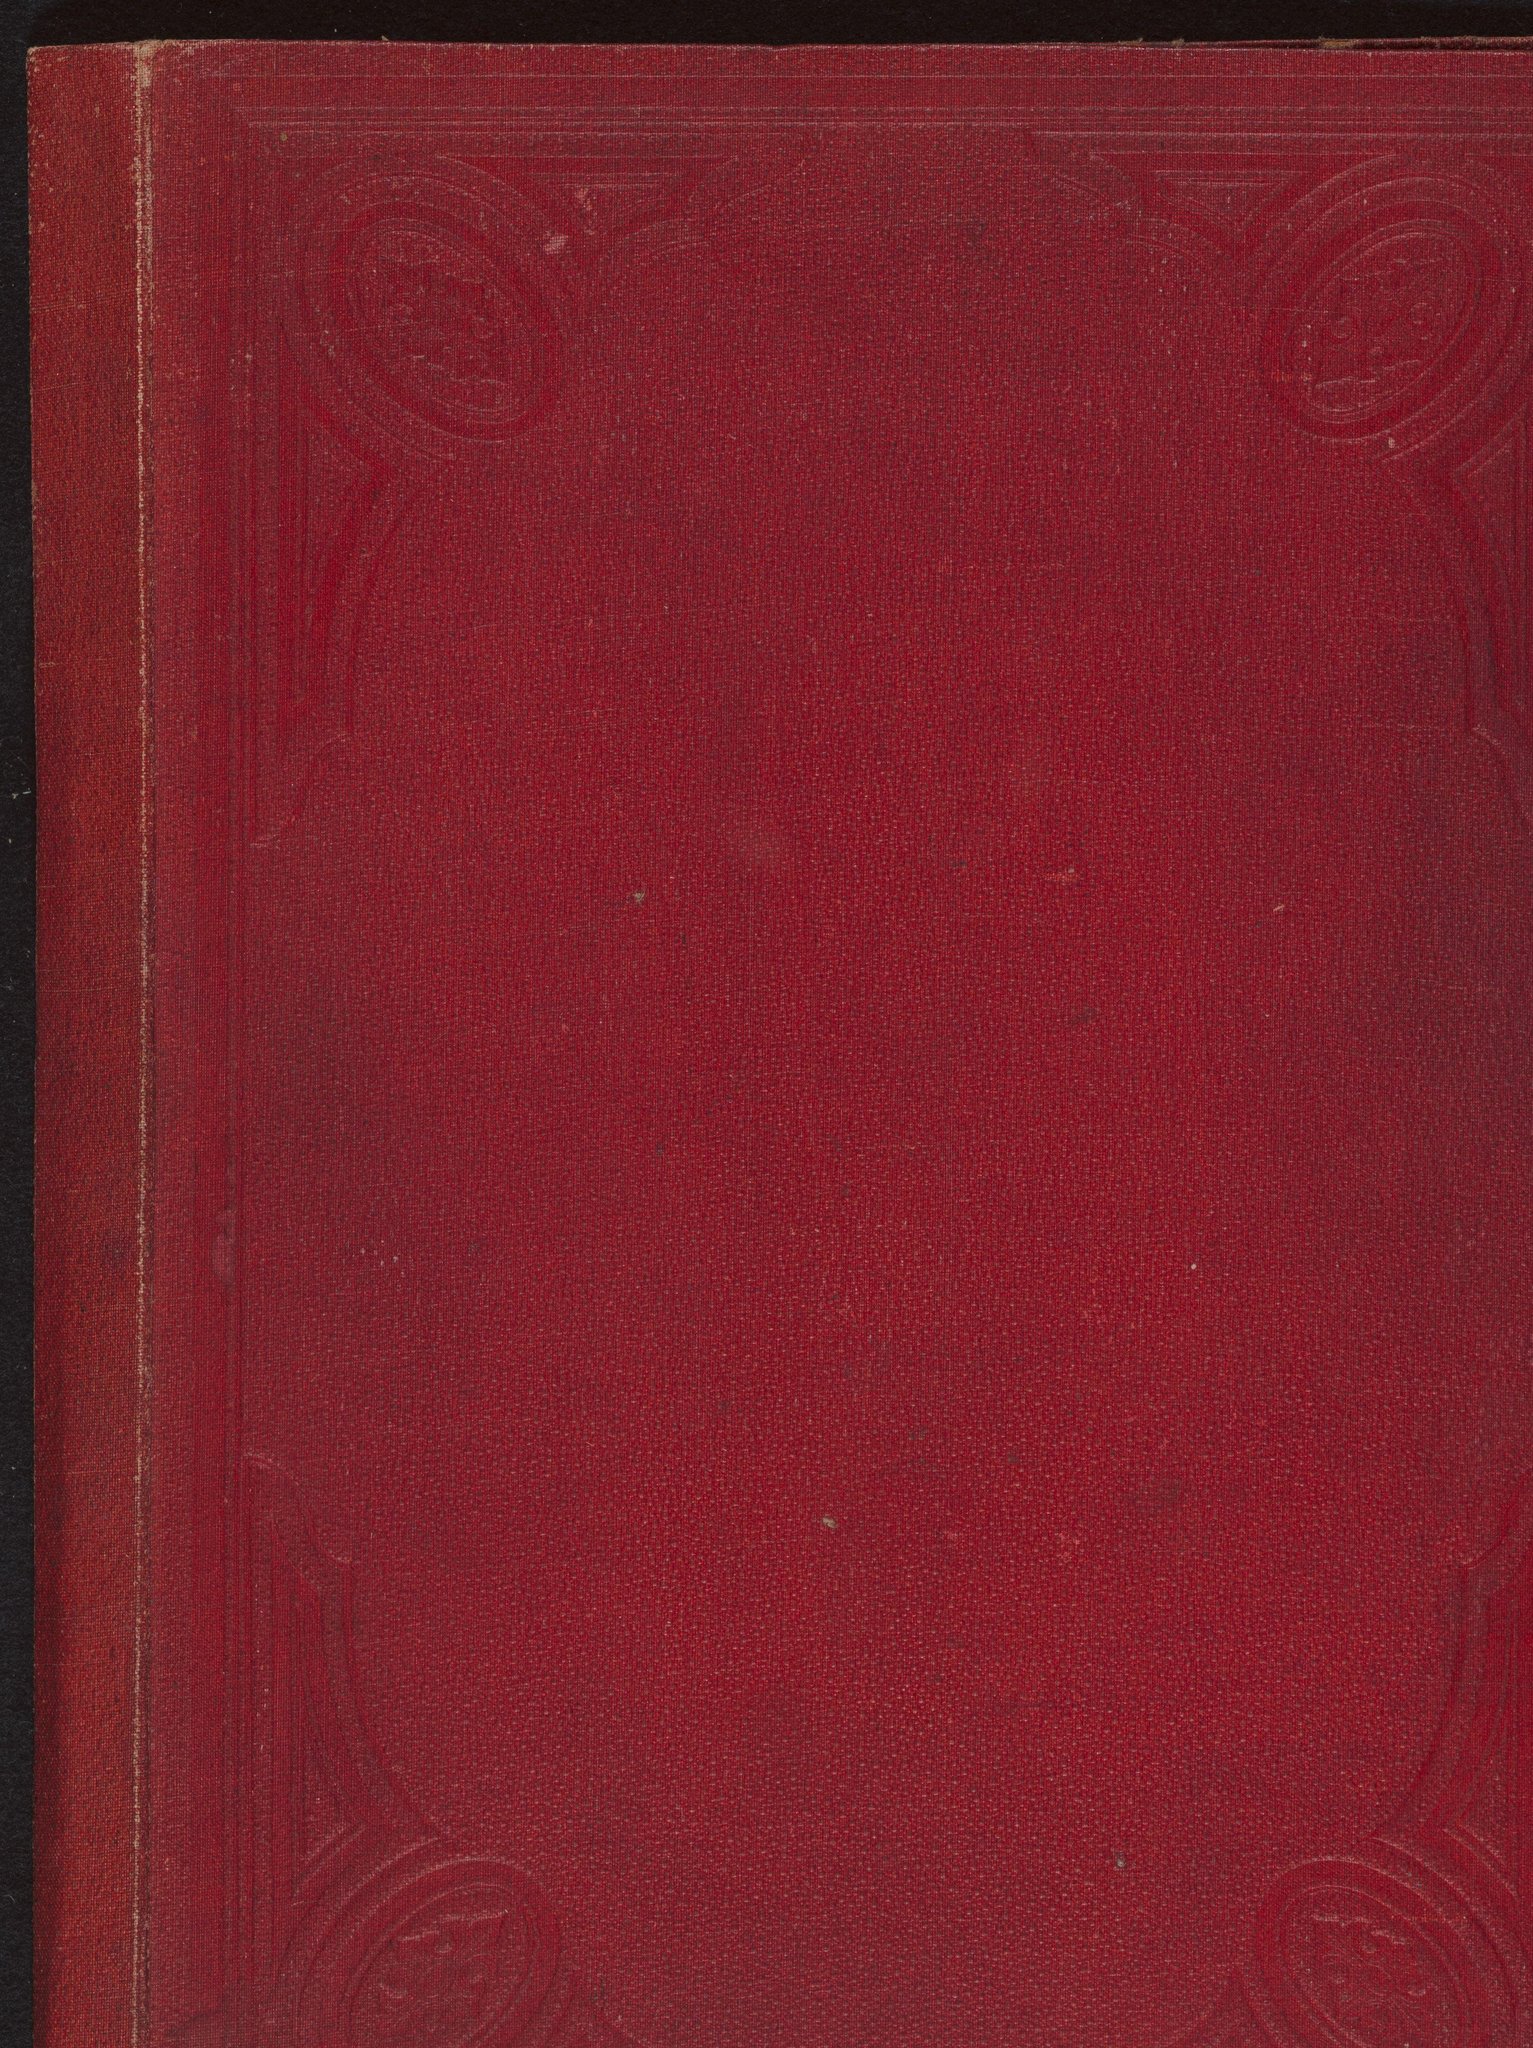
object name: prentrecueil, prentenalbum, prentalbum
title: Prentalbum met collages van uitgeknipte prenten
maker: Anonymous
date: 1870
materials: paper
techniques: bookbinding, engraving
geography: paris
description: Album met rode omslag en 18 bladen. Voorzien van uitgeknipte prenten, vermoedelijk afkomstig uit 19e-eeuwse tijdschiften, in een decoratieve, vaak symmetrische compositie.